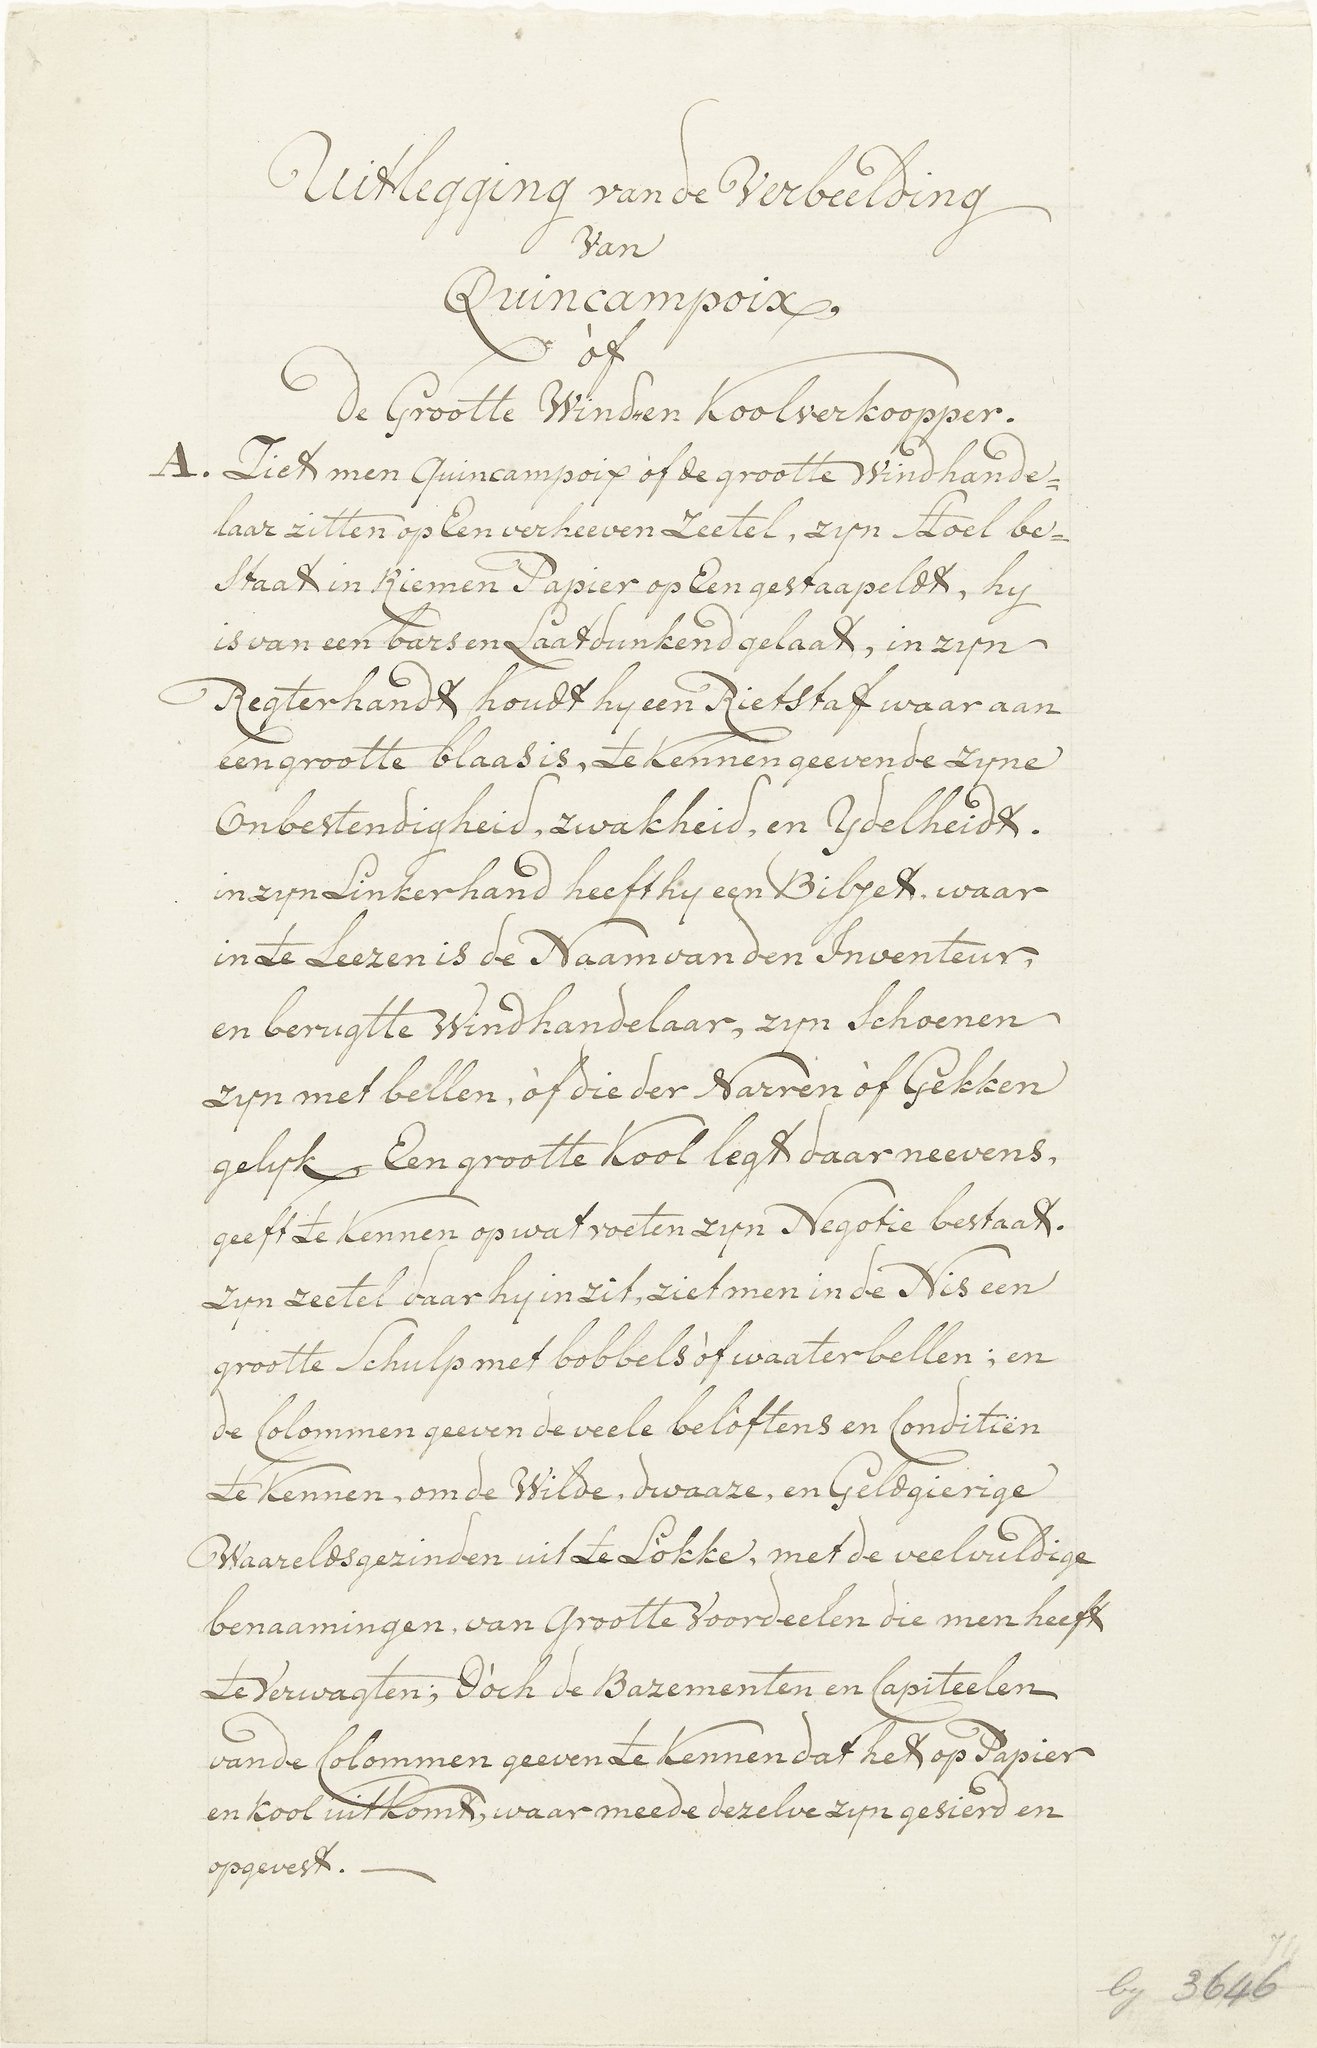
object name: manuscript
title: Uitlegging van de Verbeelding van Quincampoix of de Grootte Wind- en Koolverkoper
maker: Anonymous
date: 1720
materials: paper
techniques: writing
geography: northern netherlands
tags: john law, windhandel van 1720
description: Handgeschreven verklaring van de voorstelling van de tekening Quincampoix of de grote Wind en Koolverkoper. Dubbelgevouwen blad met een verklaring van de letters A-L. Behoort tot de groep van tekeningen toegevoegd aan de serie Tafereel der Dwaasheid met spotprenten op de Windhandel of Actiehandel van 1720.